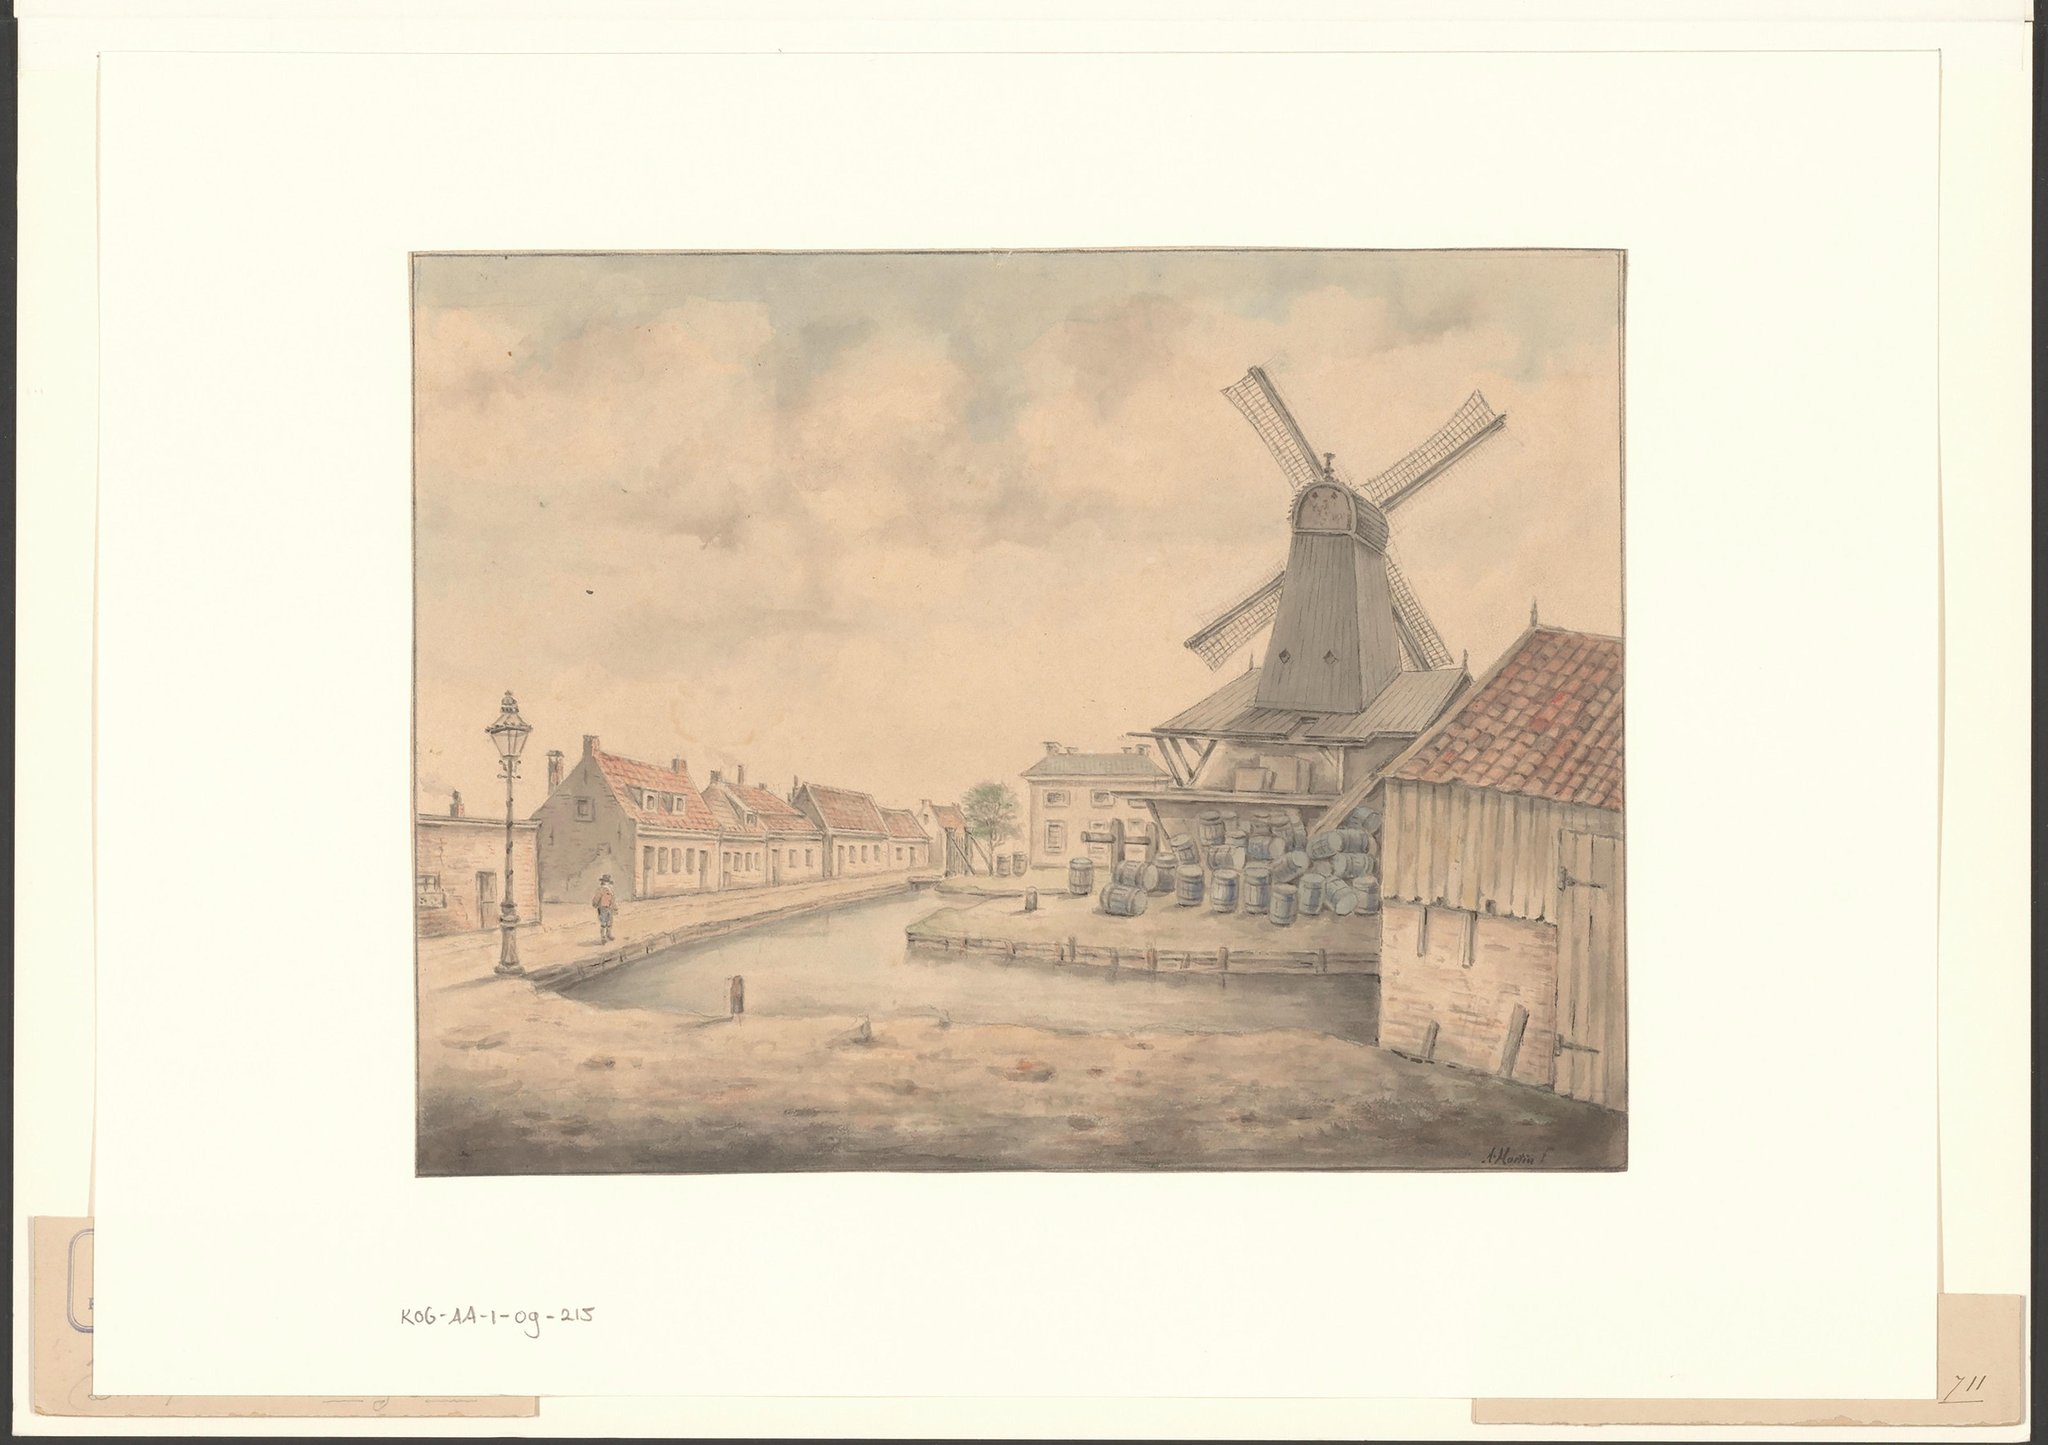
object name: drawing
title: Gezicht op het Kwakersdwarspad met molen Koning Salomon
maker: albert martin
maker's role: draughtsman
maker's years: 1827-1900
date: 1837-1900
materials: ink, paper, pencil, watercolor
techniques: brush, pen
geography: amsterdam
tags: city-view in general; 'veduta', road, path, windmill in landscape, small canal, ditch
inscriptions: inscription: ‘Kwakers / Dwarspad Molen Koning Salomon / Atlas D.C. Meijer Jr 711’, inscription: ‘Port. 9-215’, signature: ‘AMartin f’, collector's mark: ‘9’ Lugt 1641b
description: Onderwerpsrubriek binnen de Atlas Amsterdam: Kadijksplein, Karthuizerkerkhof, Kattegat, Kattenburg, Kapelsteeg O.Z., Enge Kerksteeg, Kerkstraat, Kinkerstraat, Kolk O.Z., Koningsplein, Kromboomsloot [Krom Boomssloot], Kostverlorenkade, Kwakersdwarspad, Kalverstraat, Keizersgracht (v.d. Brouwersgracht – Amstel), Klerensloot (Gedempte), Klimopstraat, Kloveniersburgwal, Kraansluis.